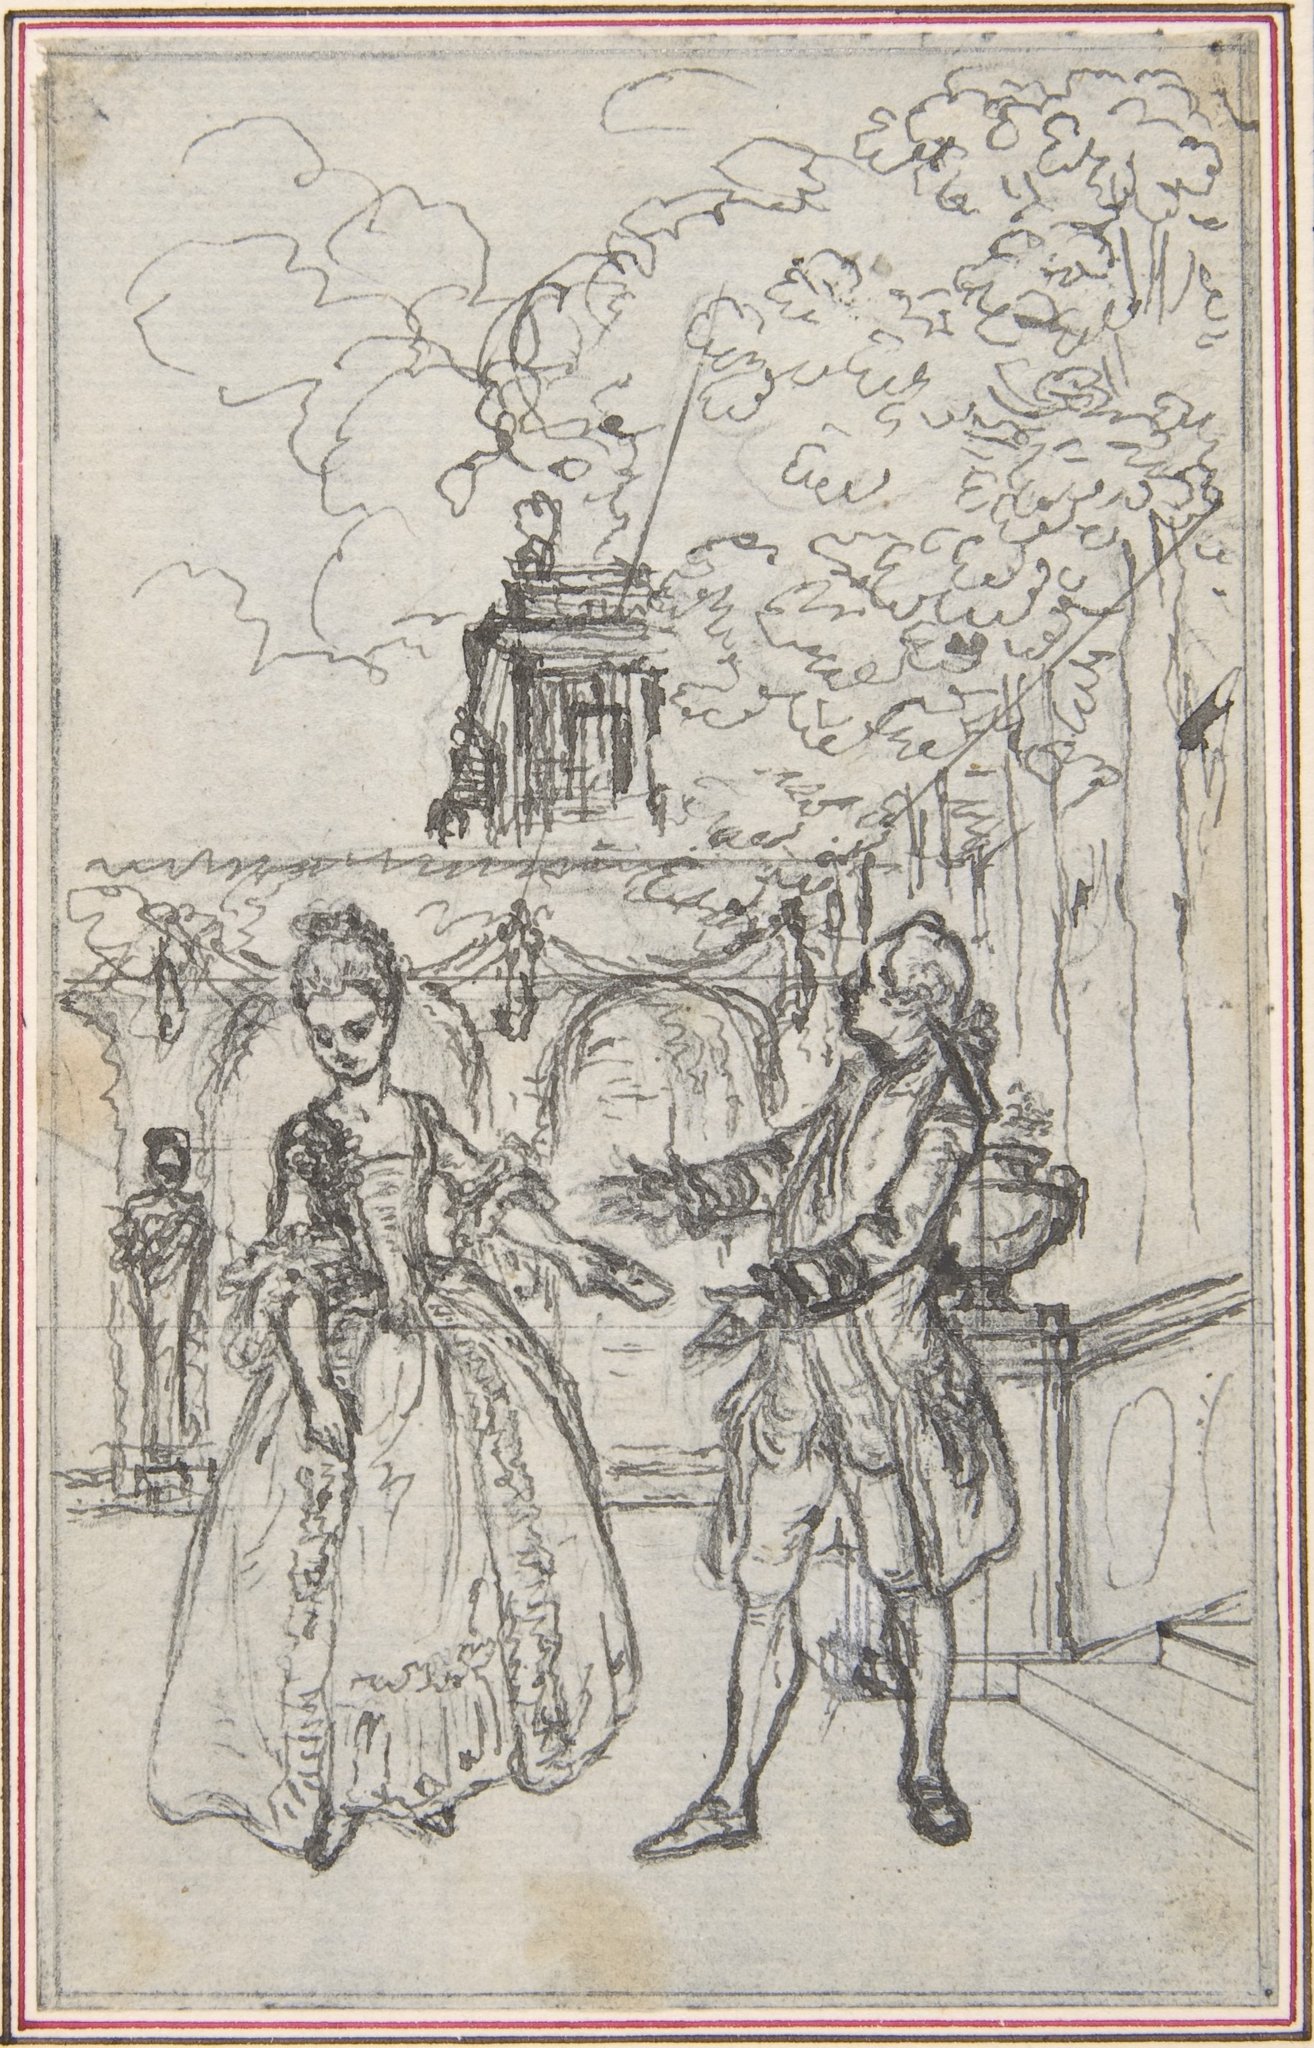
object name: drawing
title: Design for a Scene in Pierre de Laujon's "L'Amoureux de quinze ans, ou la Double-Fête..."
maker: hubert françois gravelot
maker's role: artist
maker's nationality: french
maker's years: 1699-1773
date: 1771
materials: graphite, ink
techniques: pen, drawing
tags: men,women